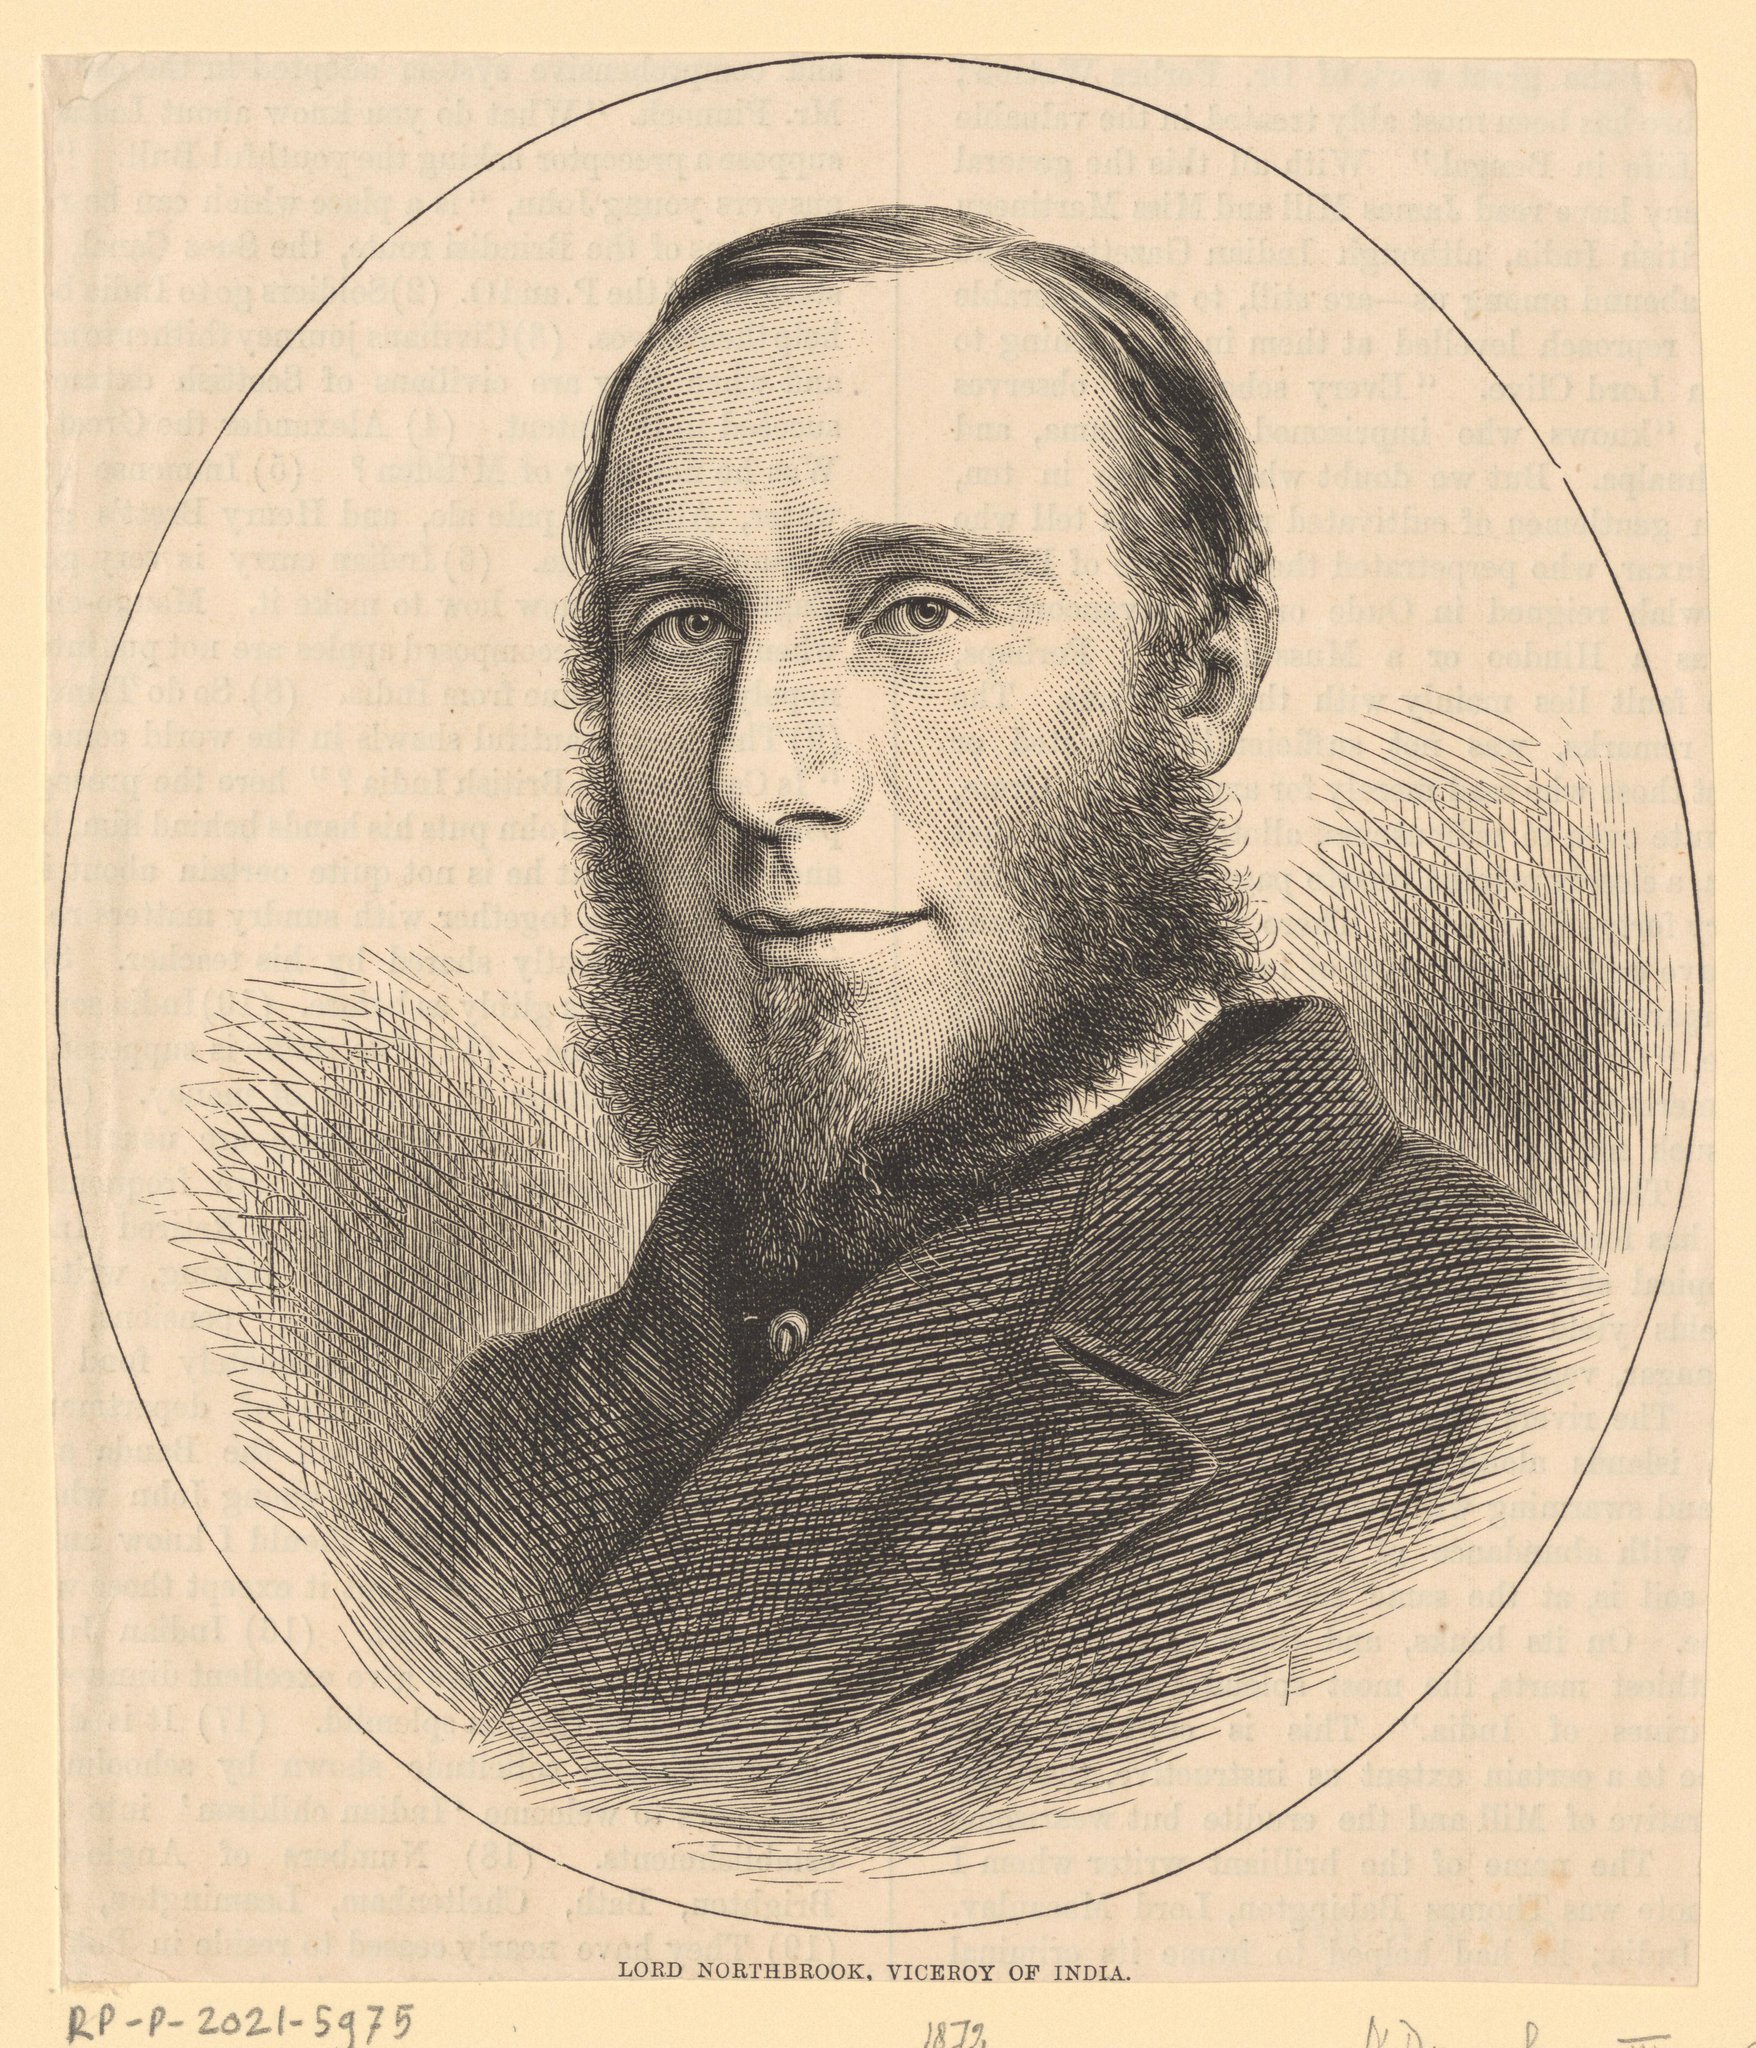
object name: print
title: Portret van Thomas George Baring, 1e graaf van Northbrook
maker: Anonymous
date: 1875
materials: paper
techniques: letterpress printing, engraving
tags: politician, historical persons, politician, e.g. party leader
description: Prent uit het bijvoegsel 'India and the Prince of Wales' van: The Illustrated London News, 1875.